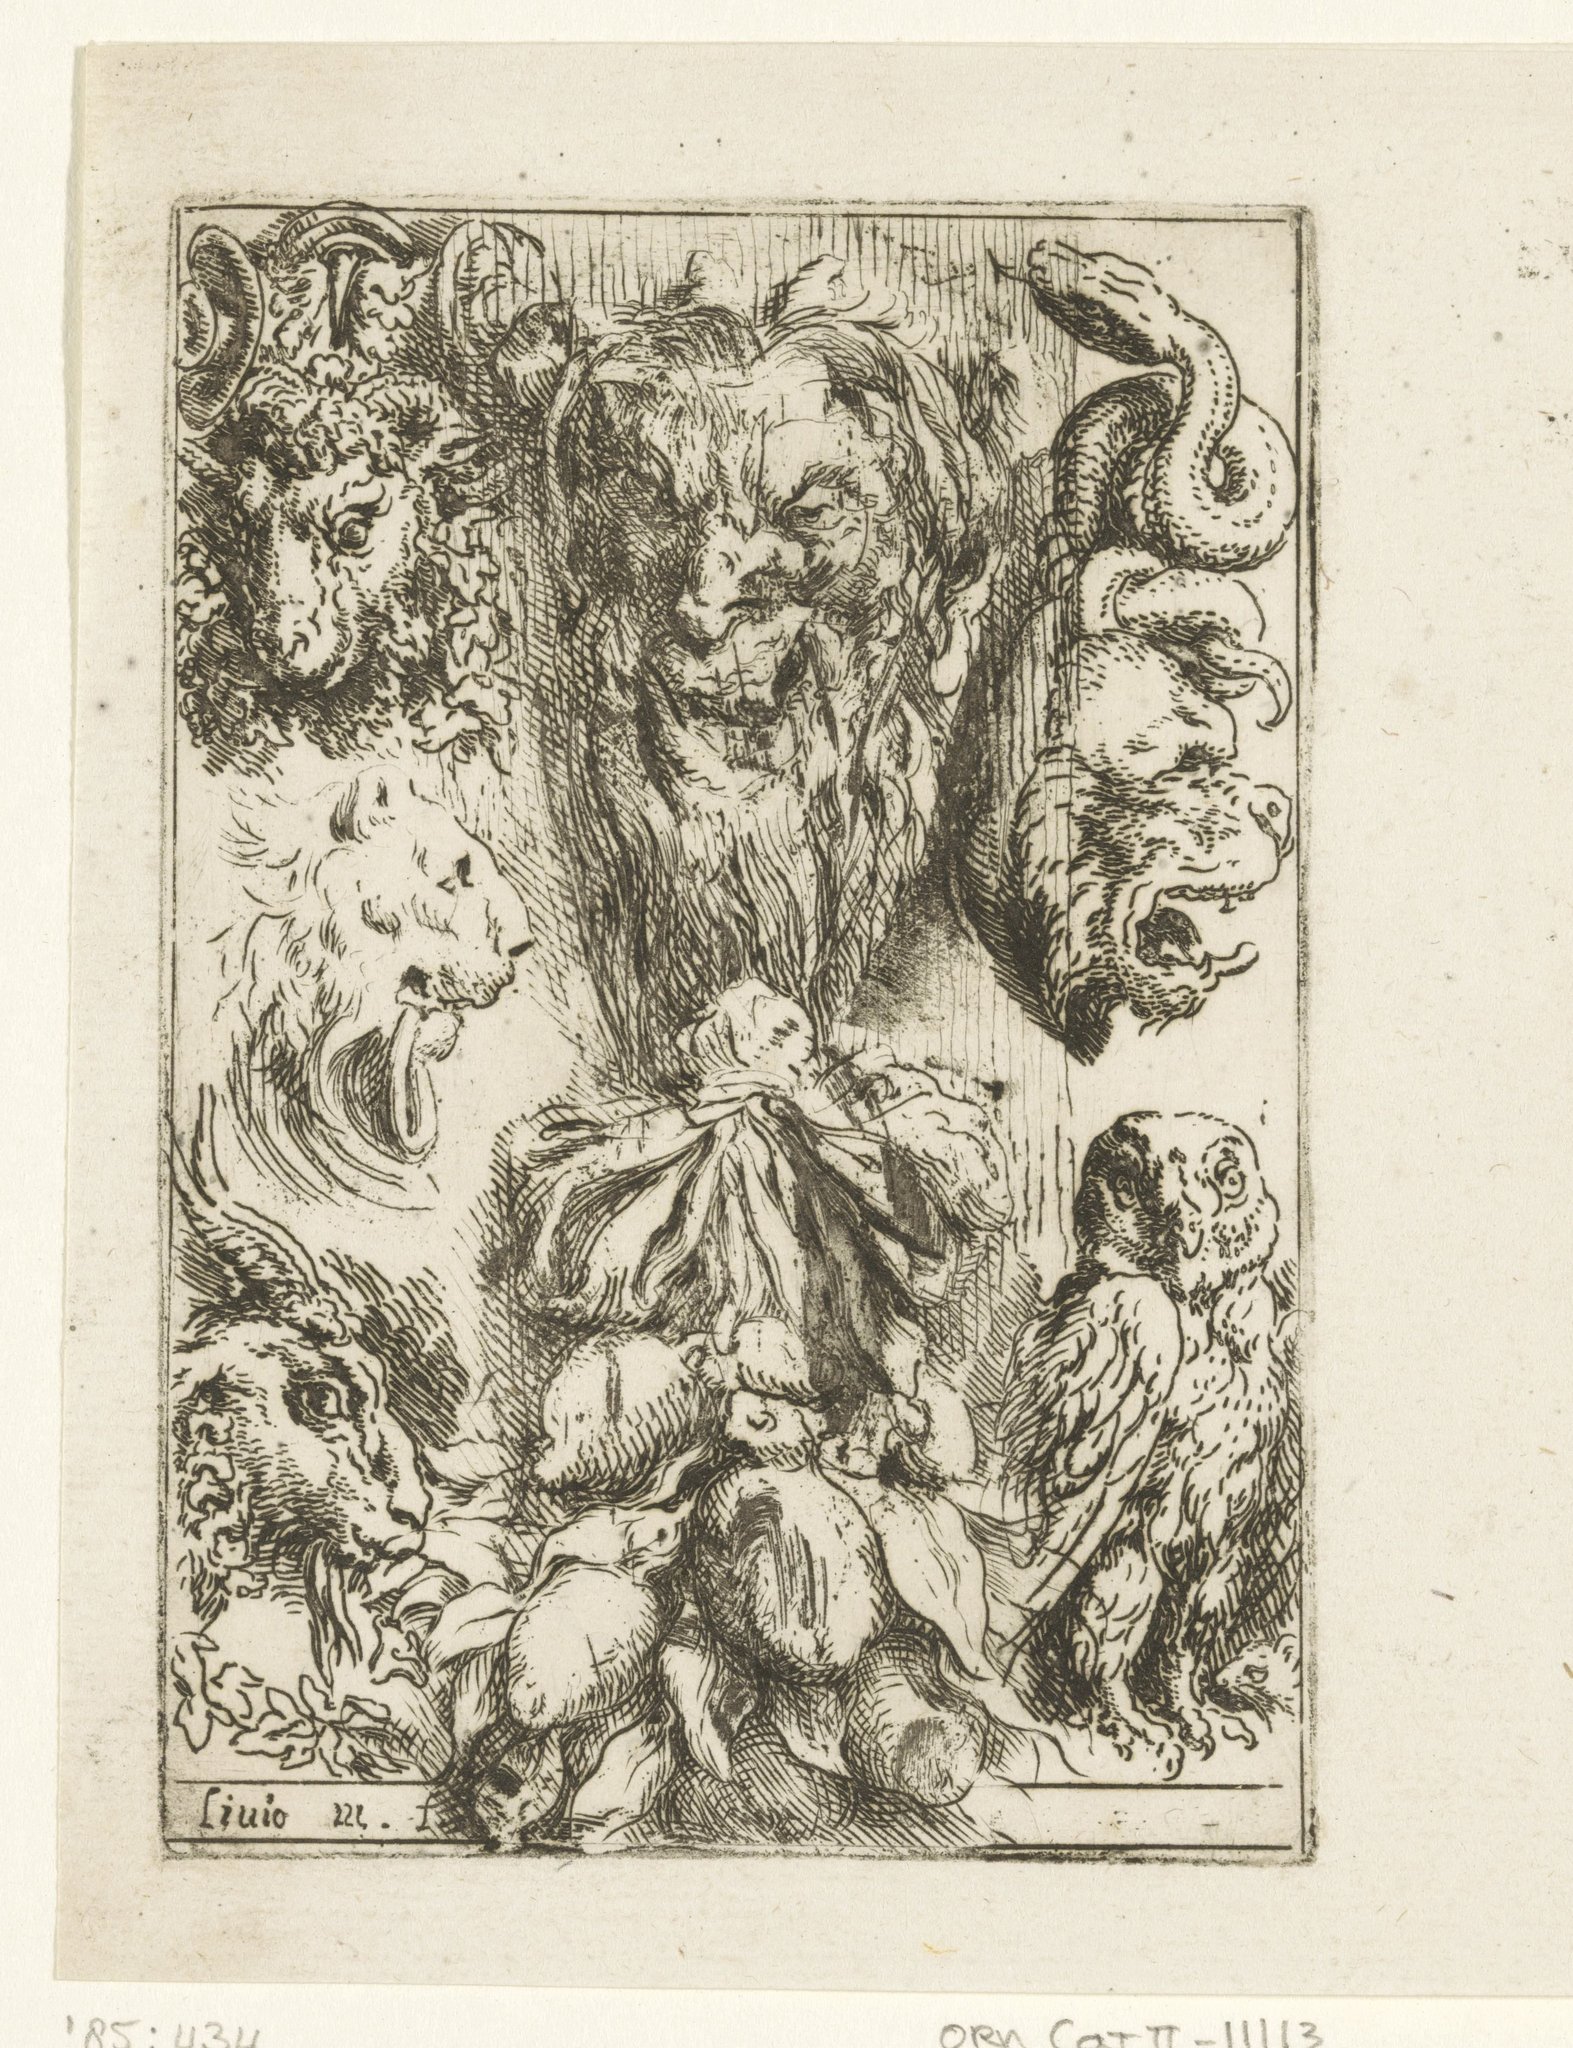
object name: ornament print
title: Verschillende dierenhoofden, een masker en een fruittrofee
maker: Anonymous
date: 1600-1699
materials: paper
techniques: etching